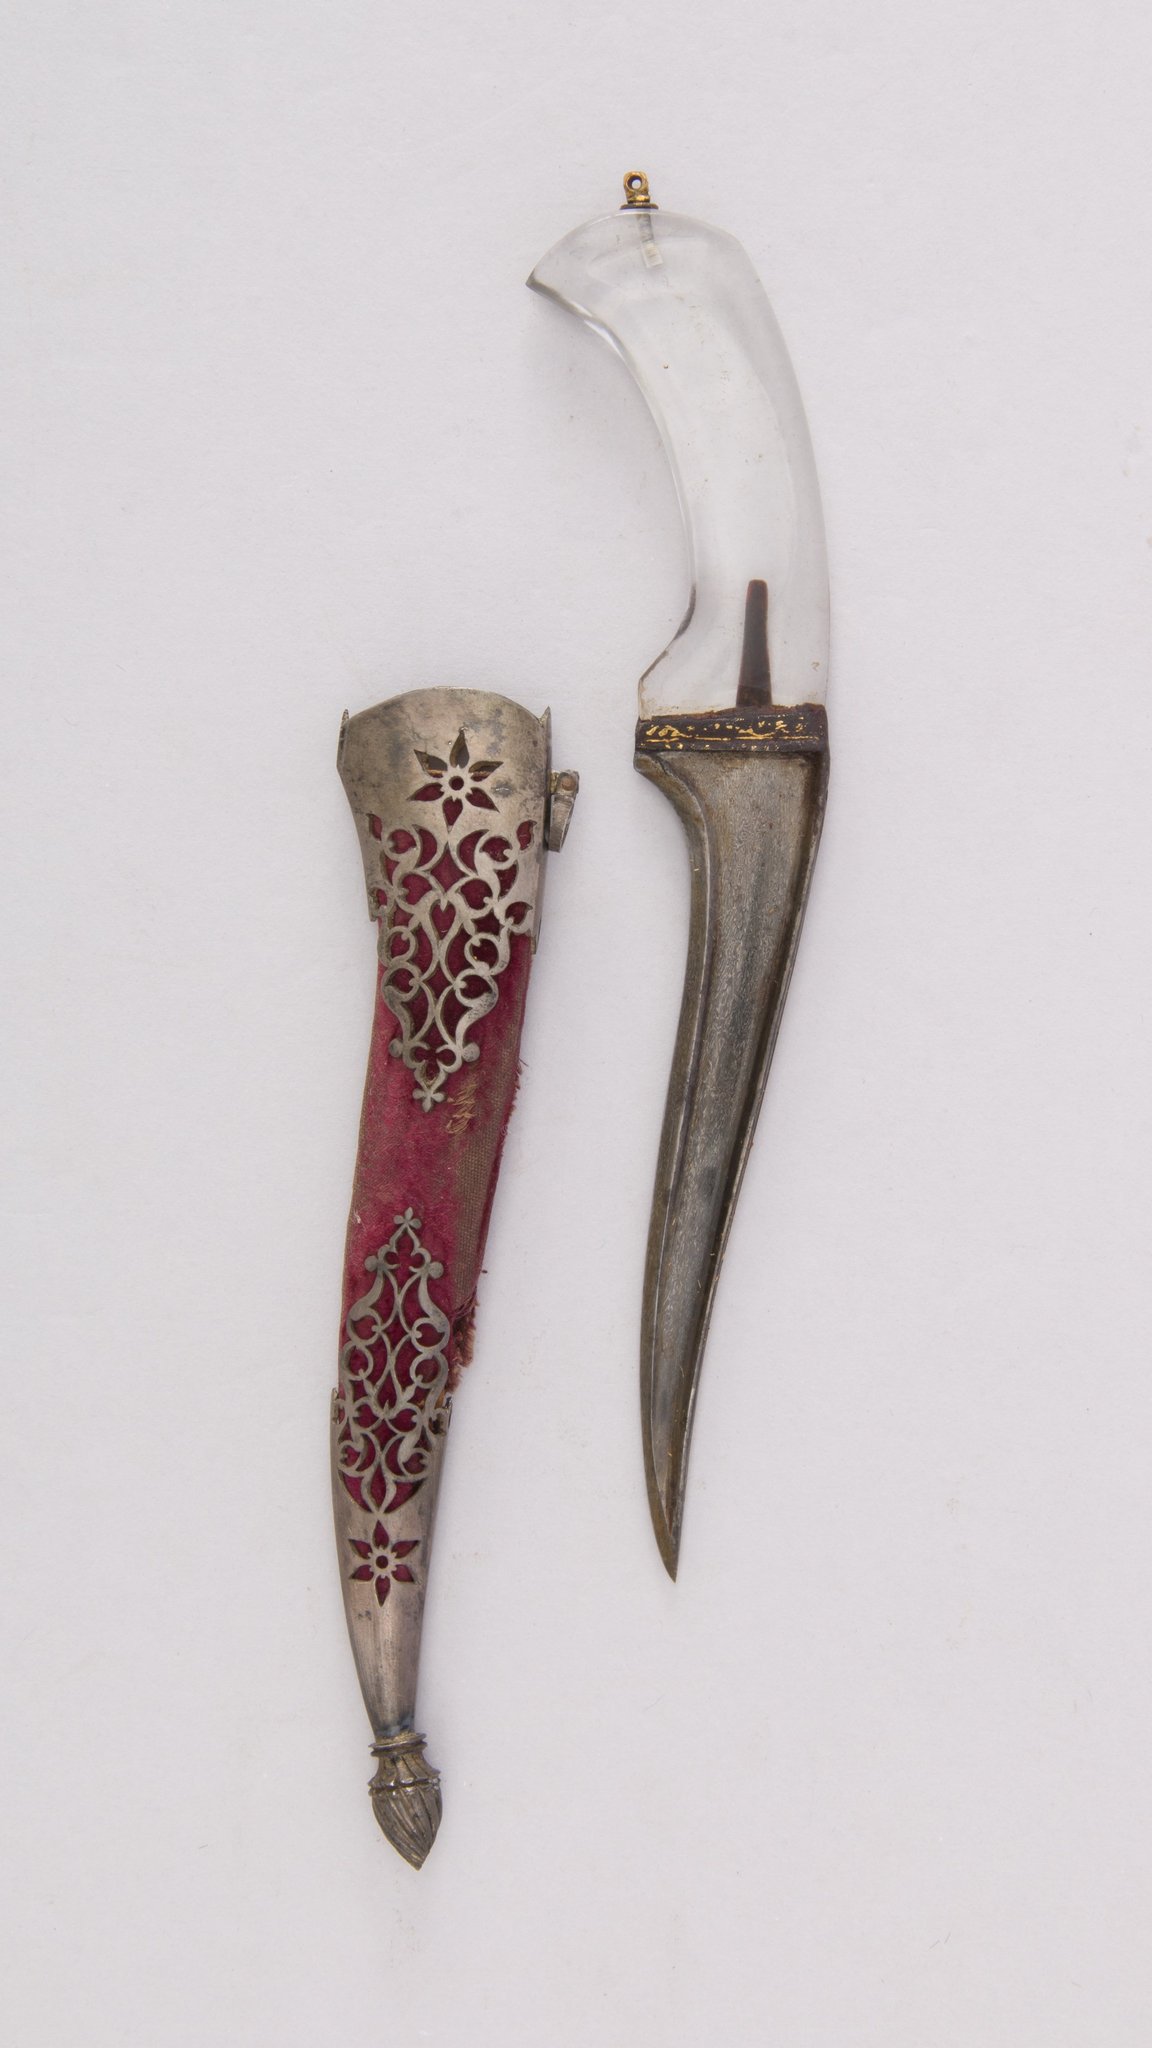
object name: dagger pesh kabz with sheath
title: Dagger (Pesh-kabz) with Sheath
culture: indian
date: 1701-1900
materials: gold, quartz, silver, steel, velvet, wood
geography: india